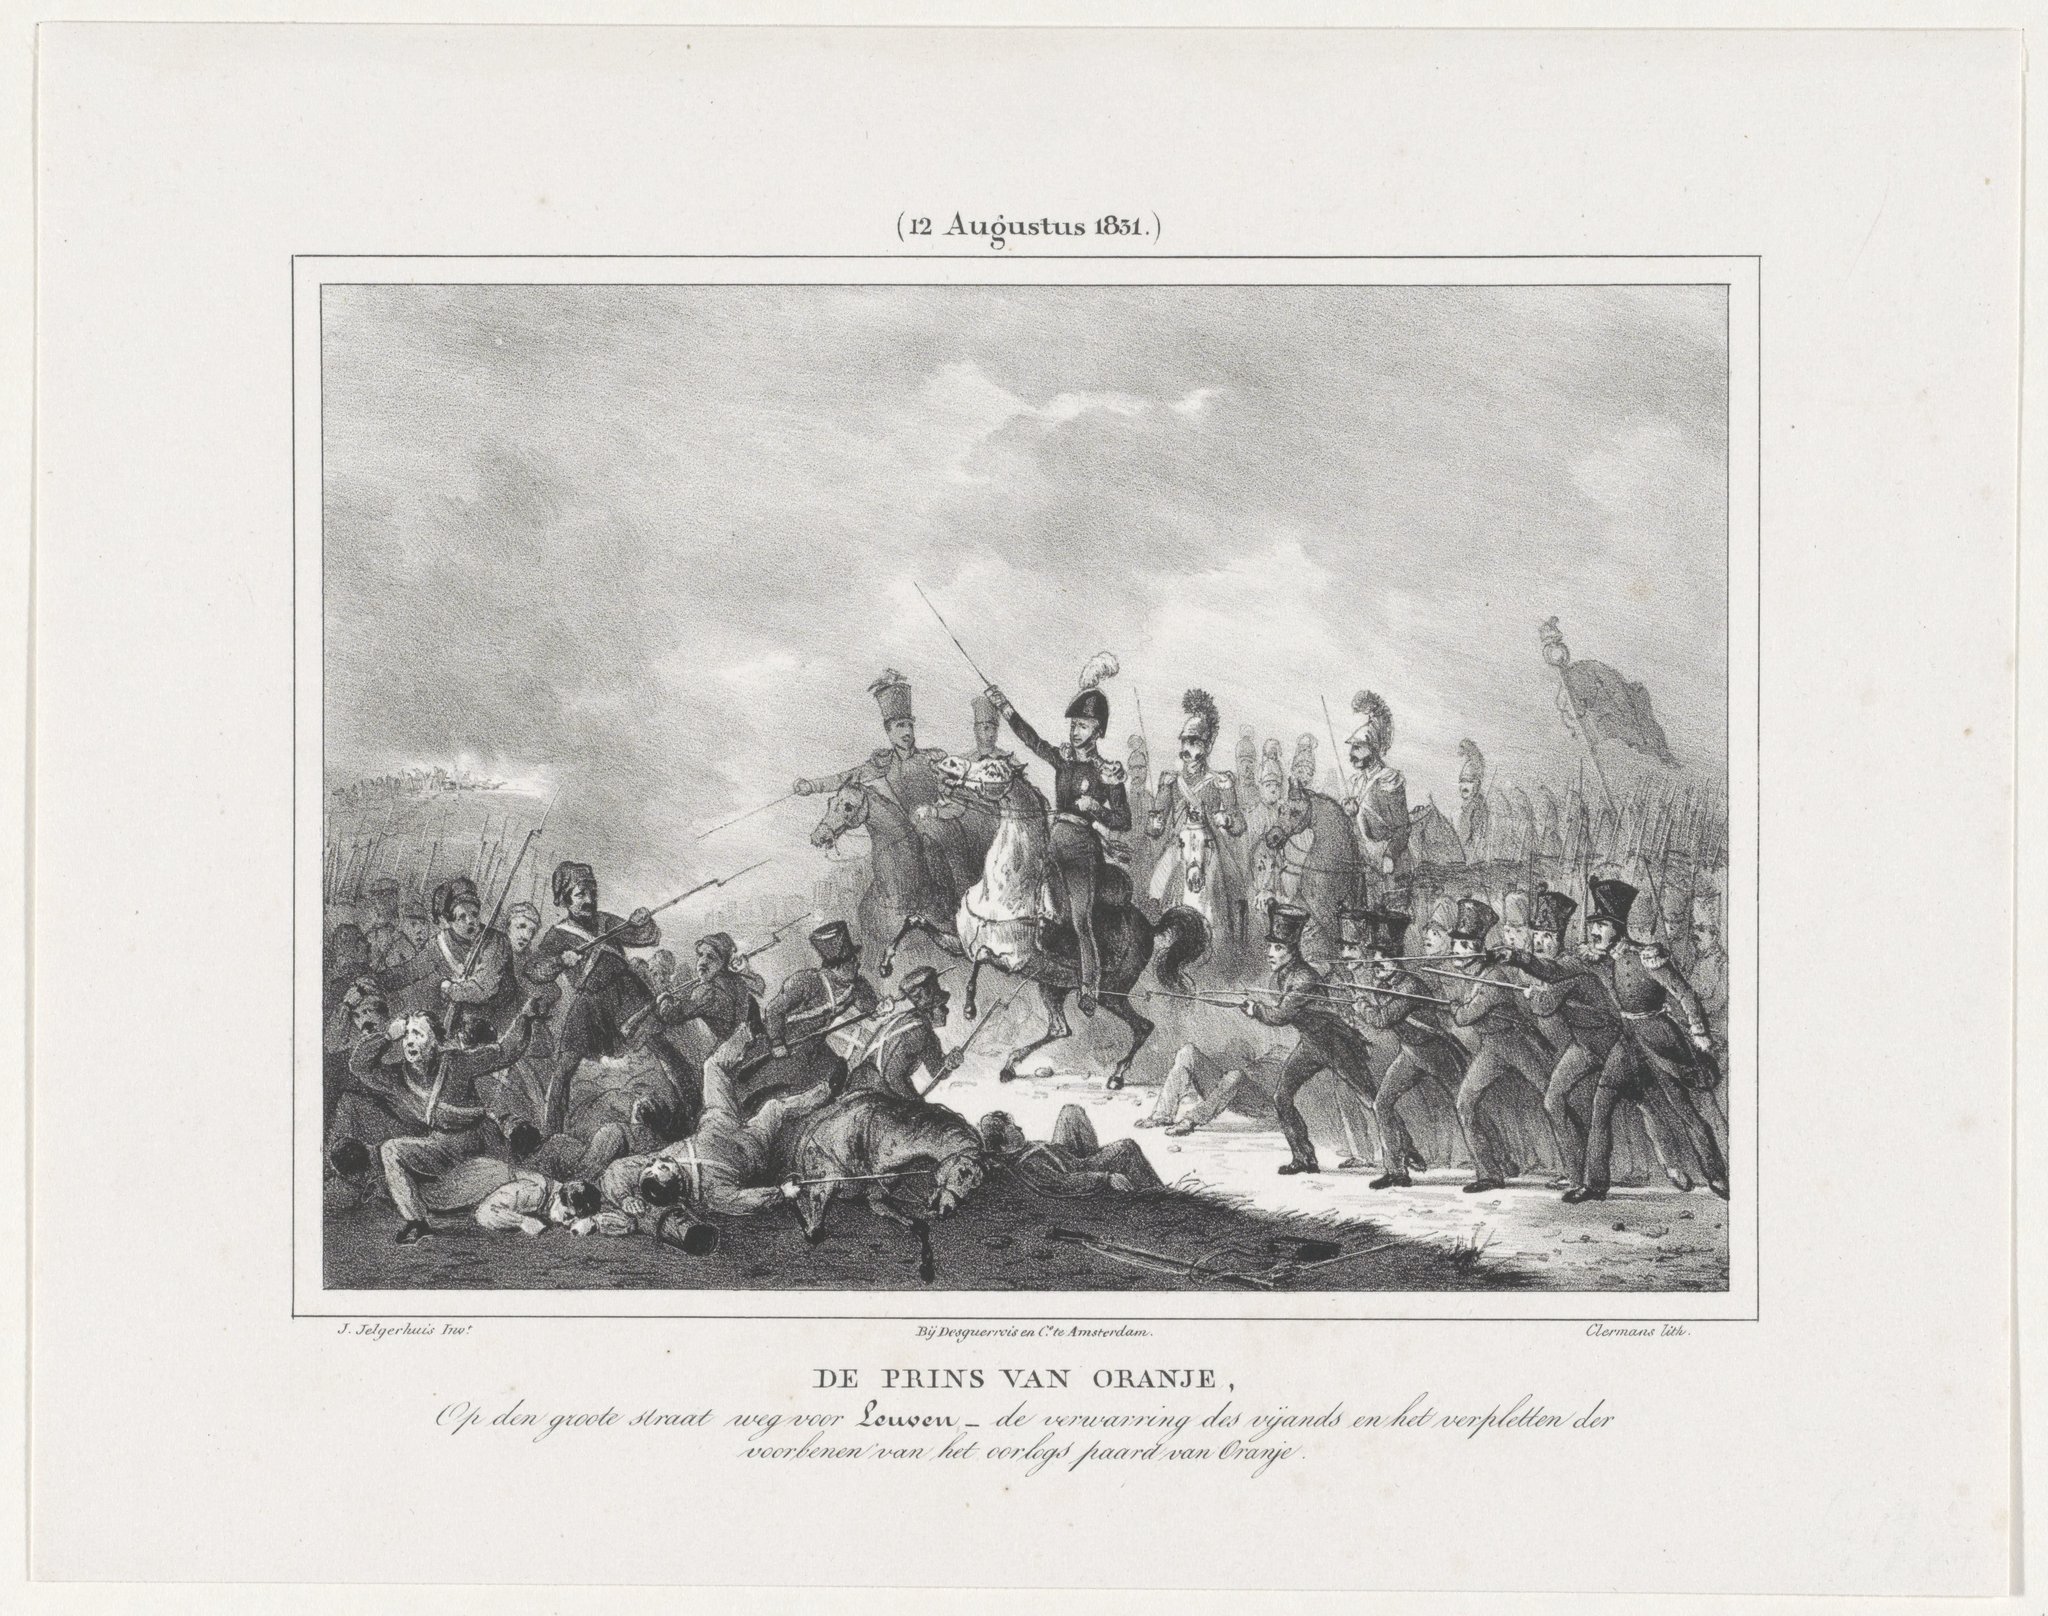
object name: print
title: Zeven platen van gevechten op 3, 8 en 12 augustus 1831 uitgegeven door Desguerrois & Co.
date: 1831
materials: paper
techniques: lithograph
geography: netherlands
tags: william ii of the netherlands, fighting horses, battle (+ land forces), louvain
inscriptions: collector's mark: Lugt 2228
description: Het paard van de prins van Oranje raakt gewond tijdens de slag bij Leuven op 12 augustus 1831. Onderdeel van een serie van zeven platen.